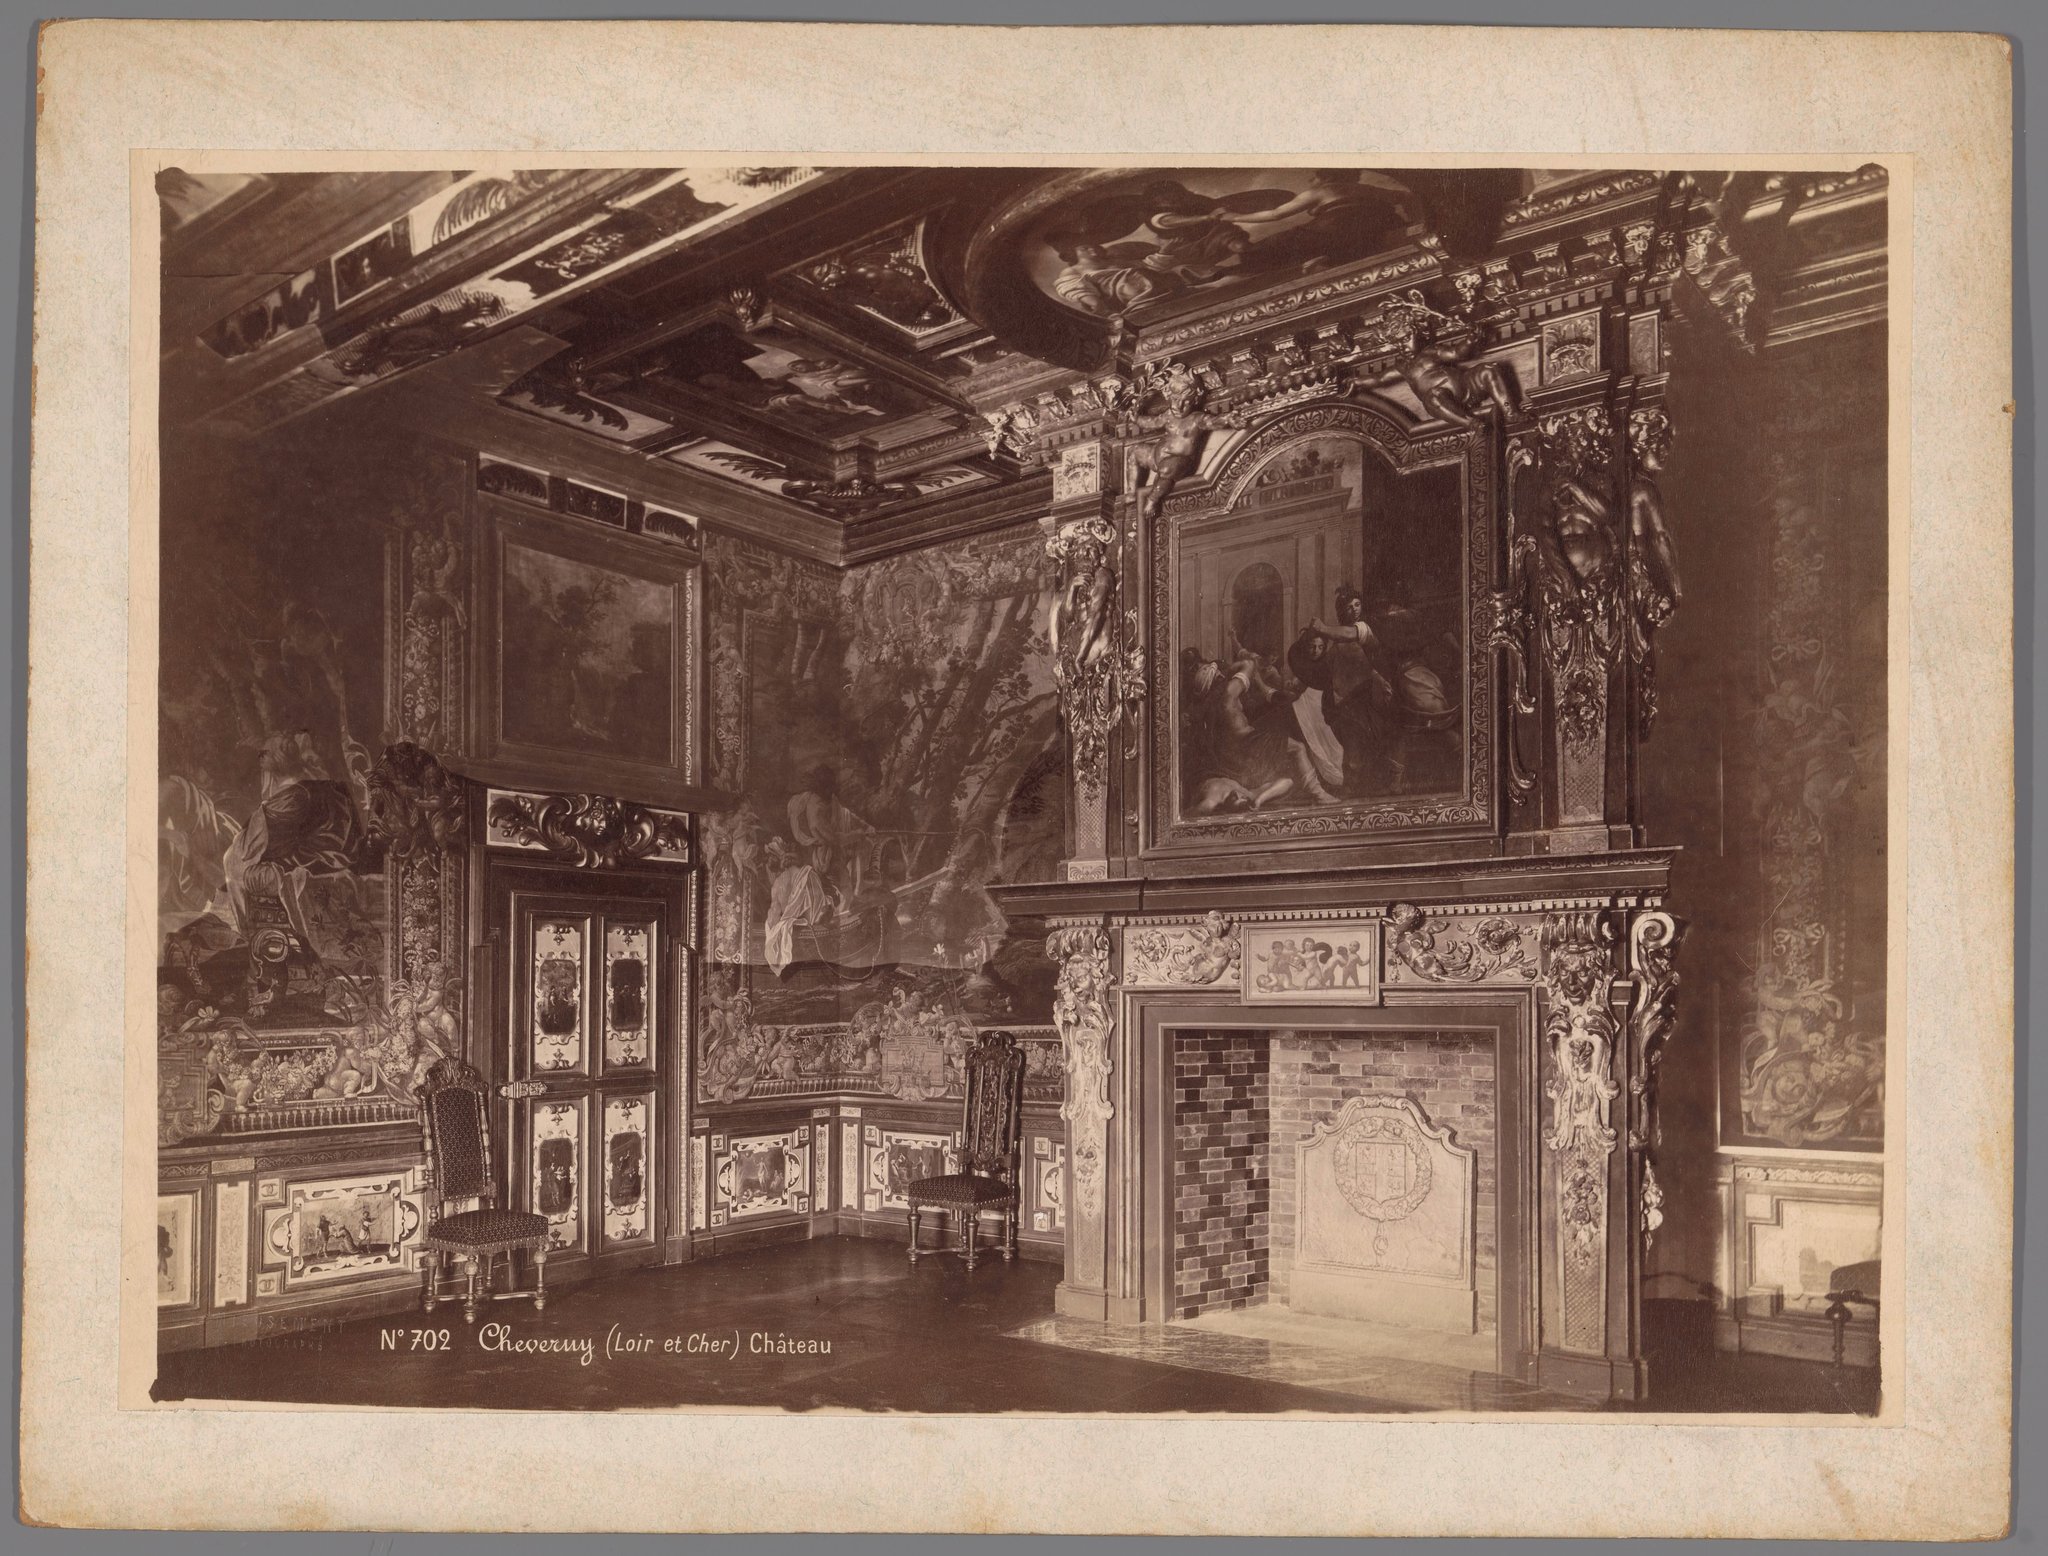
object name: photograph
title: Interieur van de Koningskamer in het Kasteel van Cheverny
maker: séraphin-médéric mieusement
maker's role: fotograaf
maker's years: 1840-1905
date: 1875-1900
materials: cardboard, photographic support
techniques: albumen print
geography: château de cheverny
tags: castle, open hearth, fire-place, interior ~ representation of a building, bedroom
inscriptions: number: ‘No 702’, name: ‘MIEUSEMENT PHOTOGRAPHE’, inscription: ‘MONUMENTS HISTORIQUES’, collector's mark: Lugt 3937